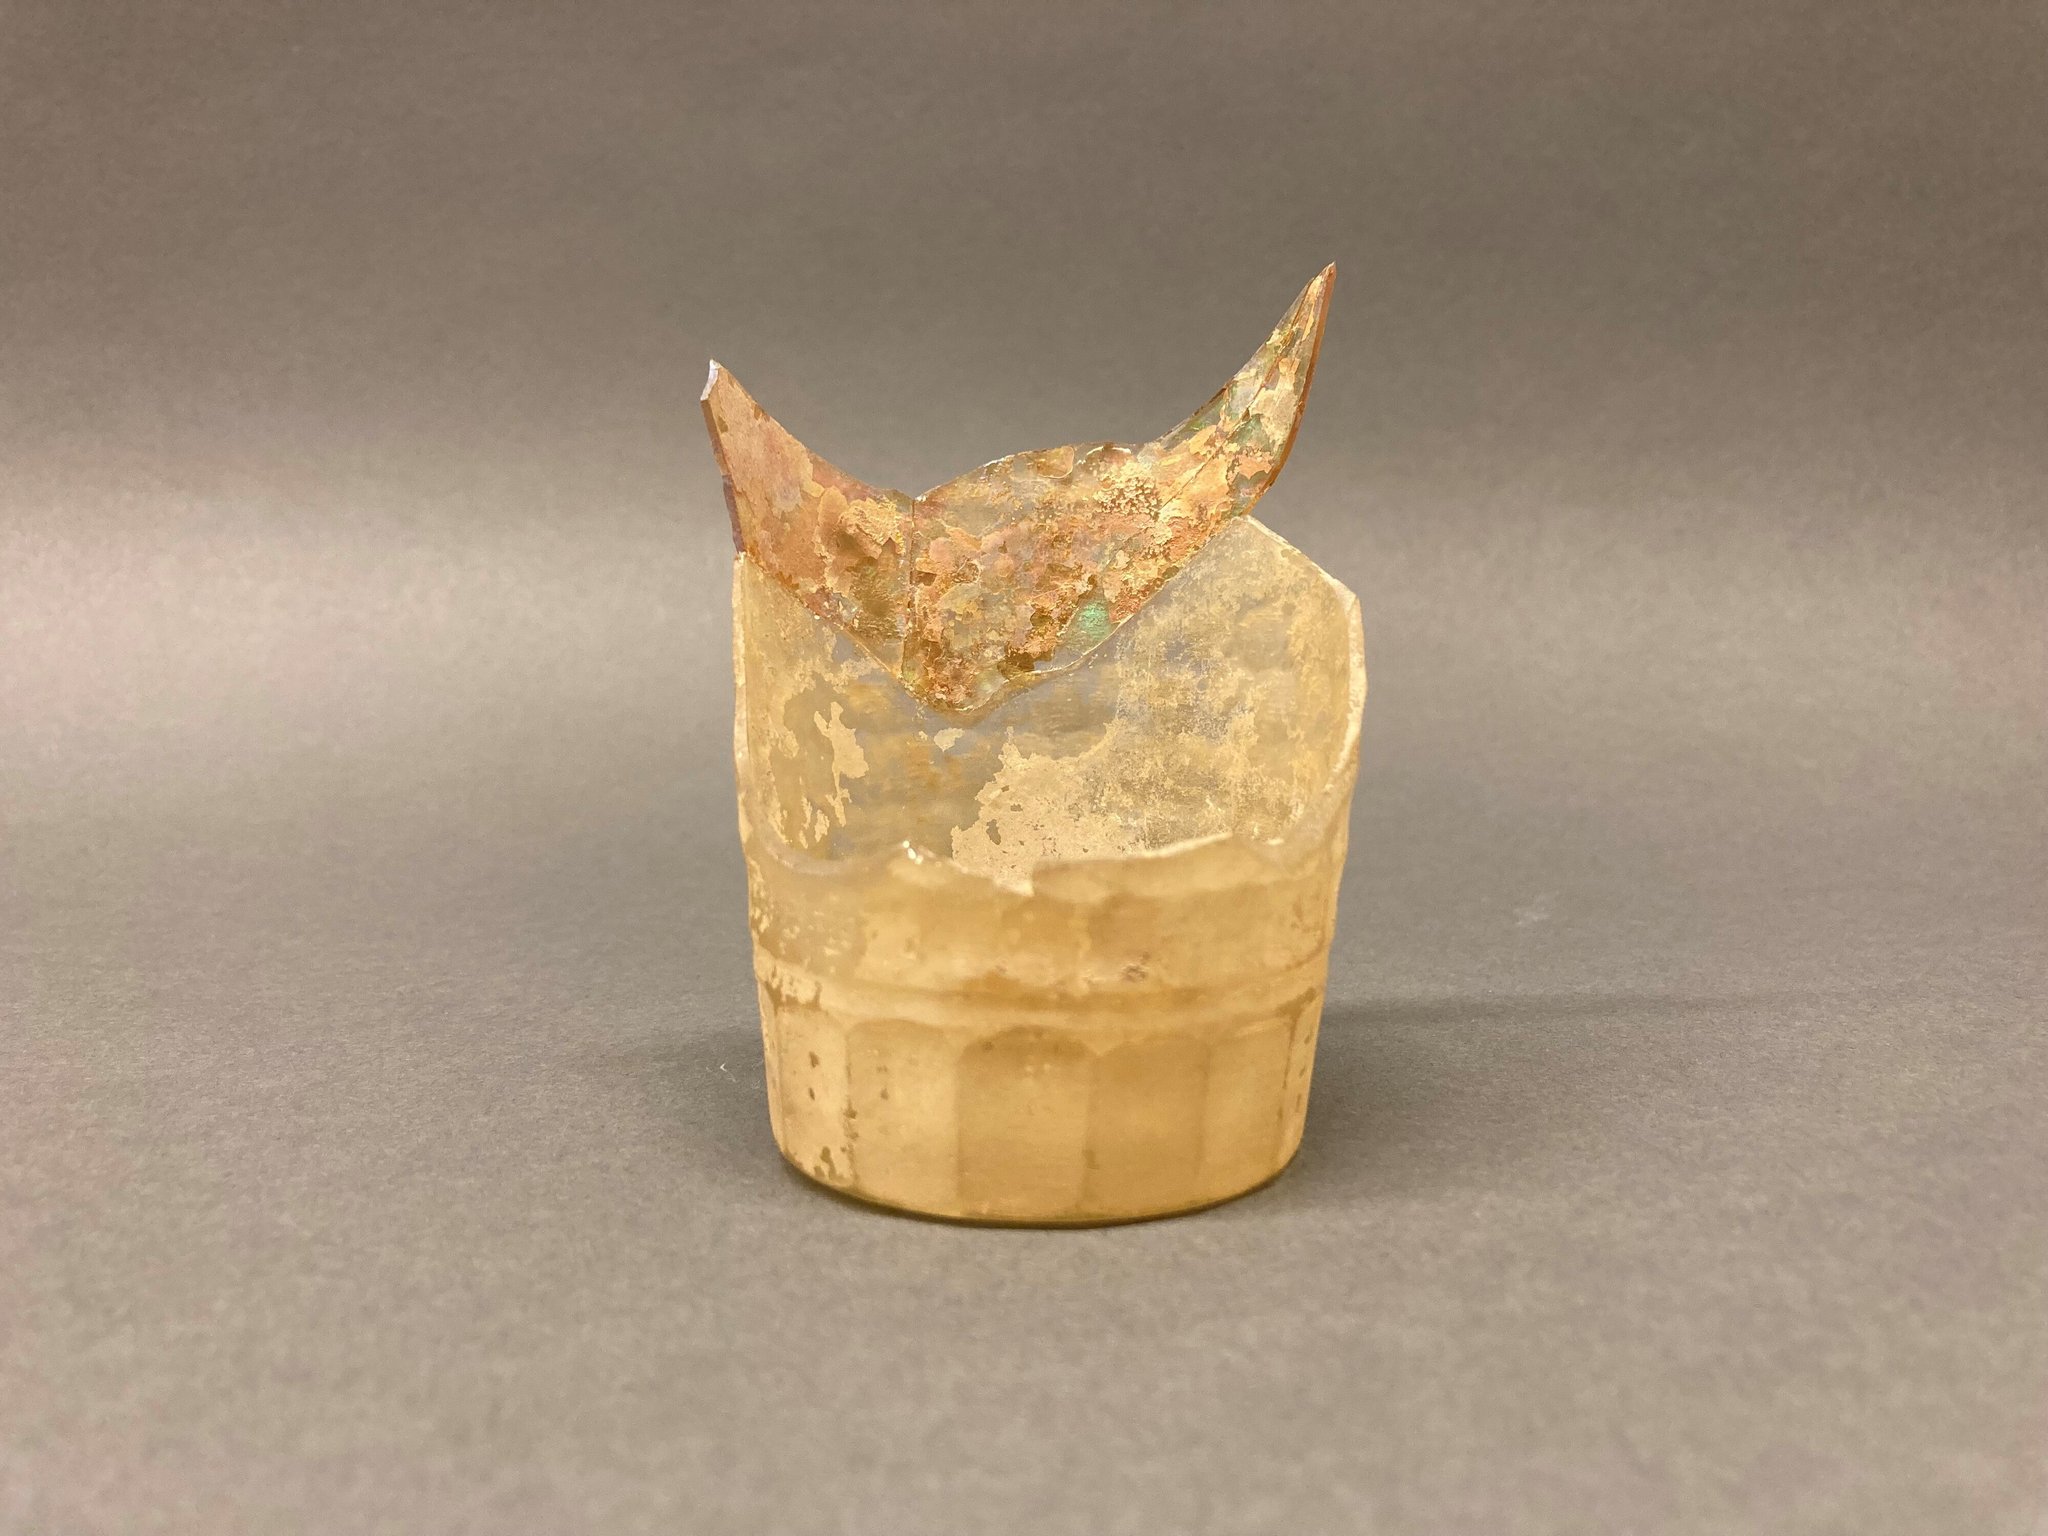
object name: fragment of a beaker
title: Beaker Fragment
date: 901-1100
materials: glass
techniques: cutting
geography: iran